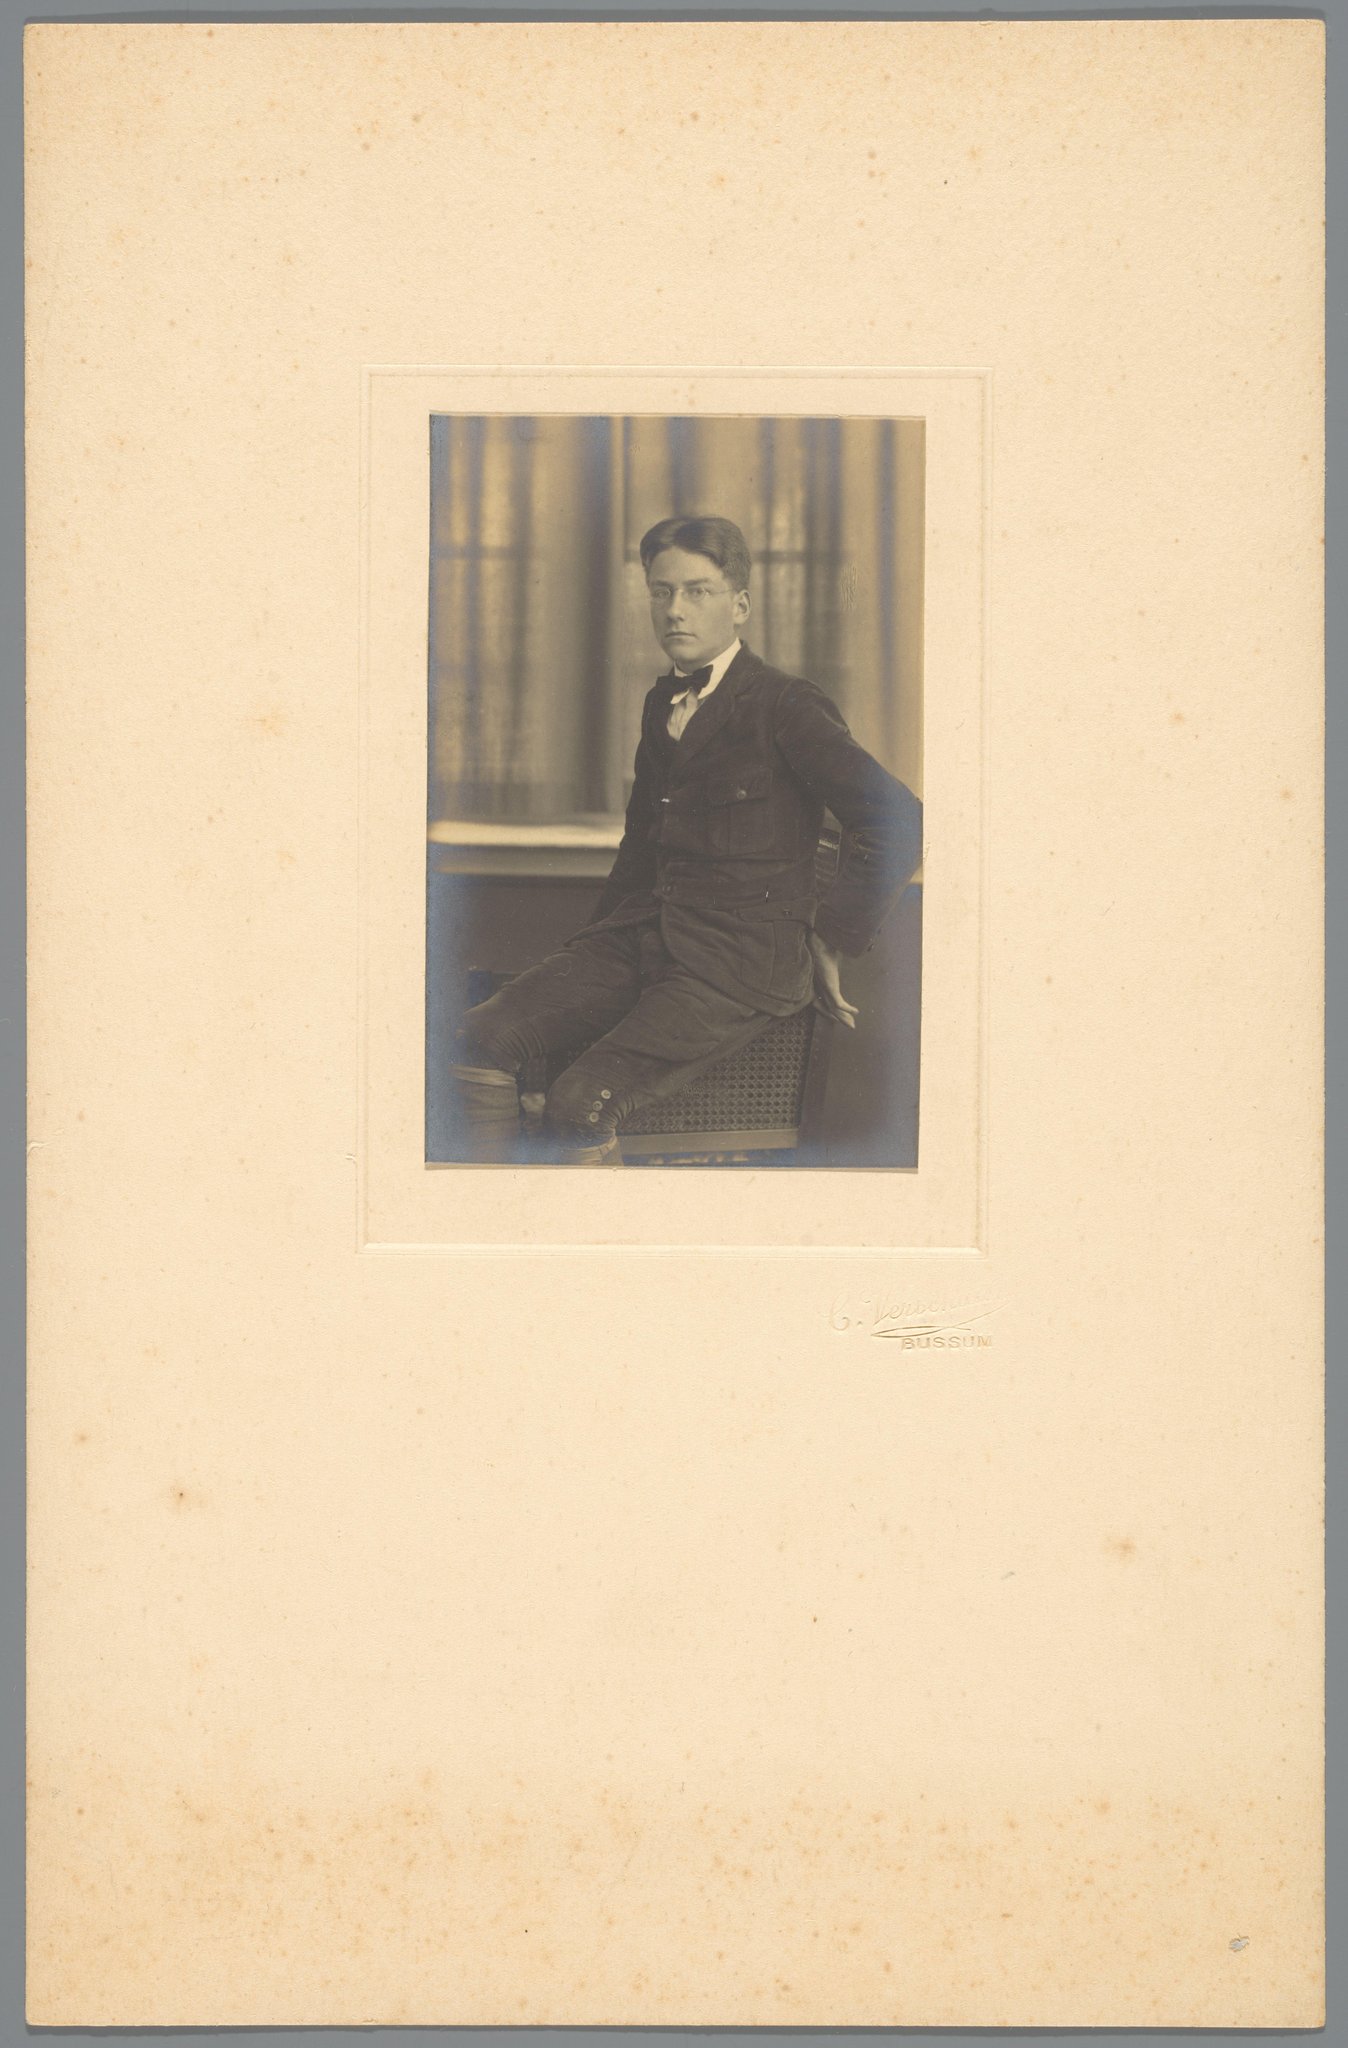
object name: photograph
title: Portret van Goverdus Henricus Jonker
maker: coenraad verschuur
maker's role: fotograaf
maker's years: 1882-1959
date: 1910-1940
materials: cardboard, photographic support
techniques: gelatin silver print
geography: bussum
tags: historical persons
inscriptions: workshop stamp: ‘C. Verschuur/ Bussum’, annotation: ‘G.H. Jonker/ geb. 6-7-1901’